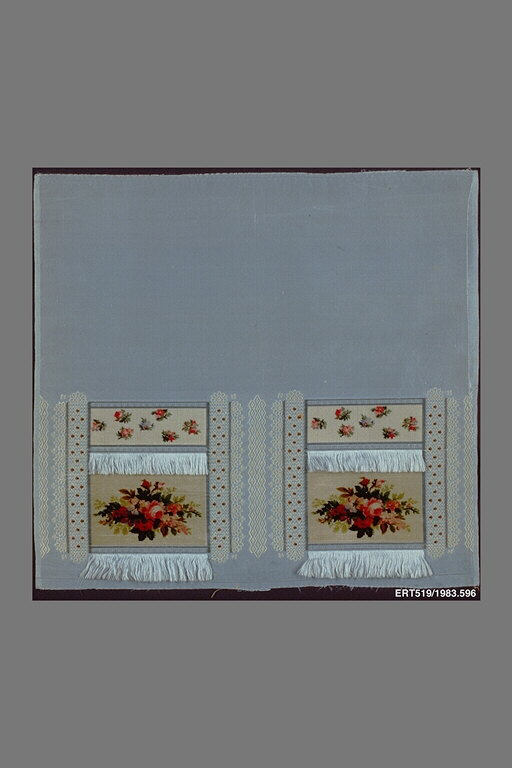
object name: panel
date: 1850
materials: silk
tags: flowers